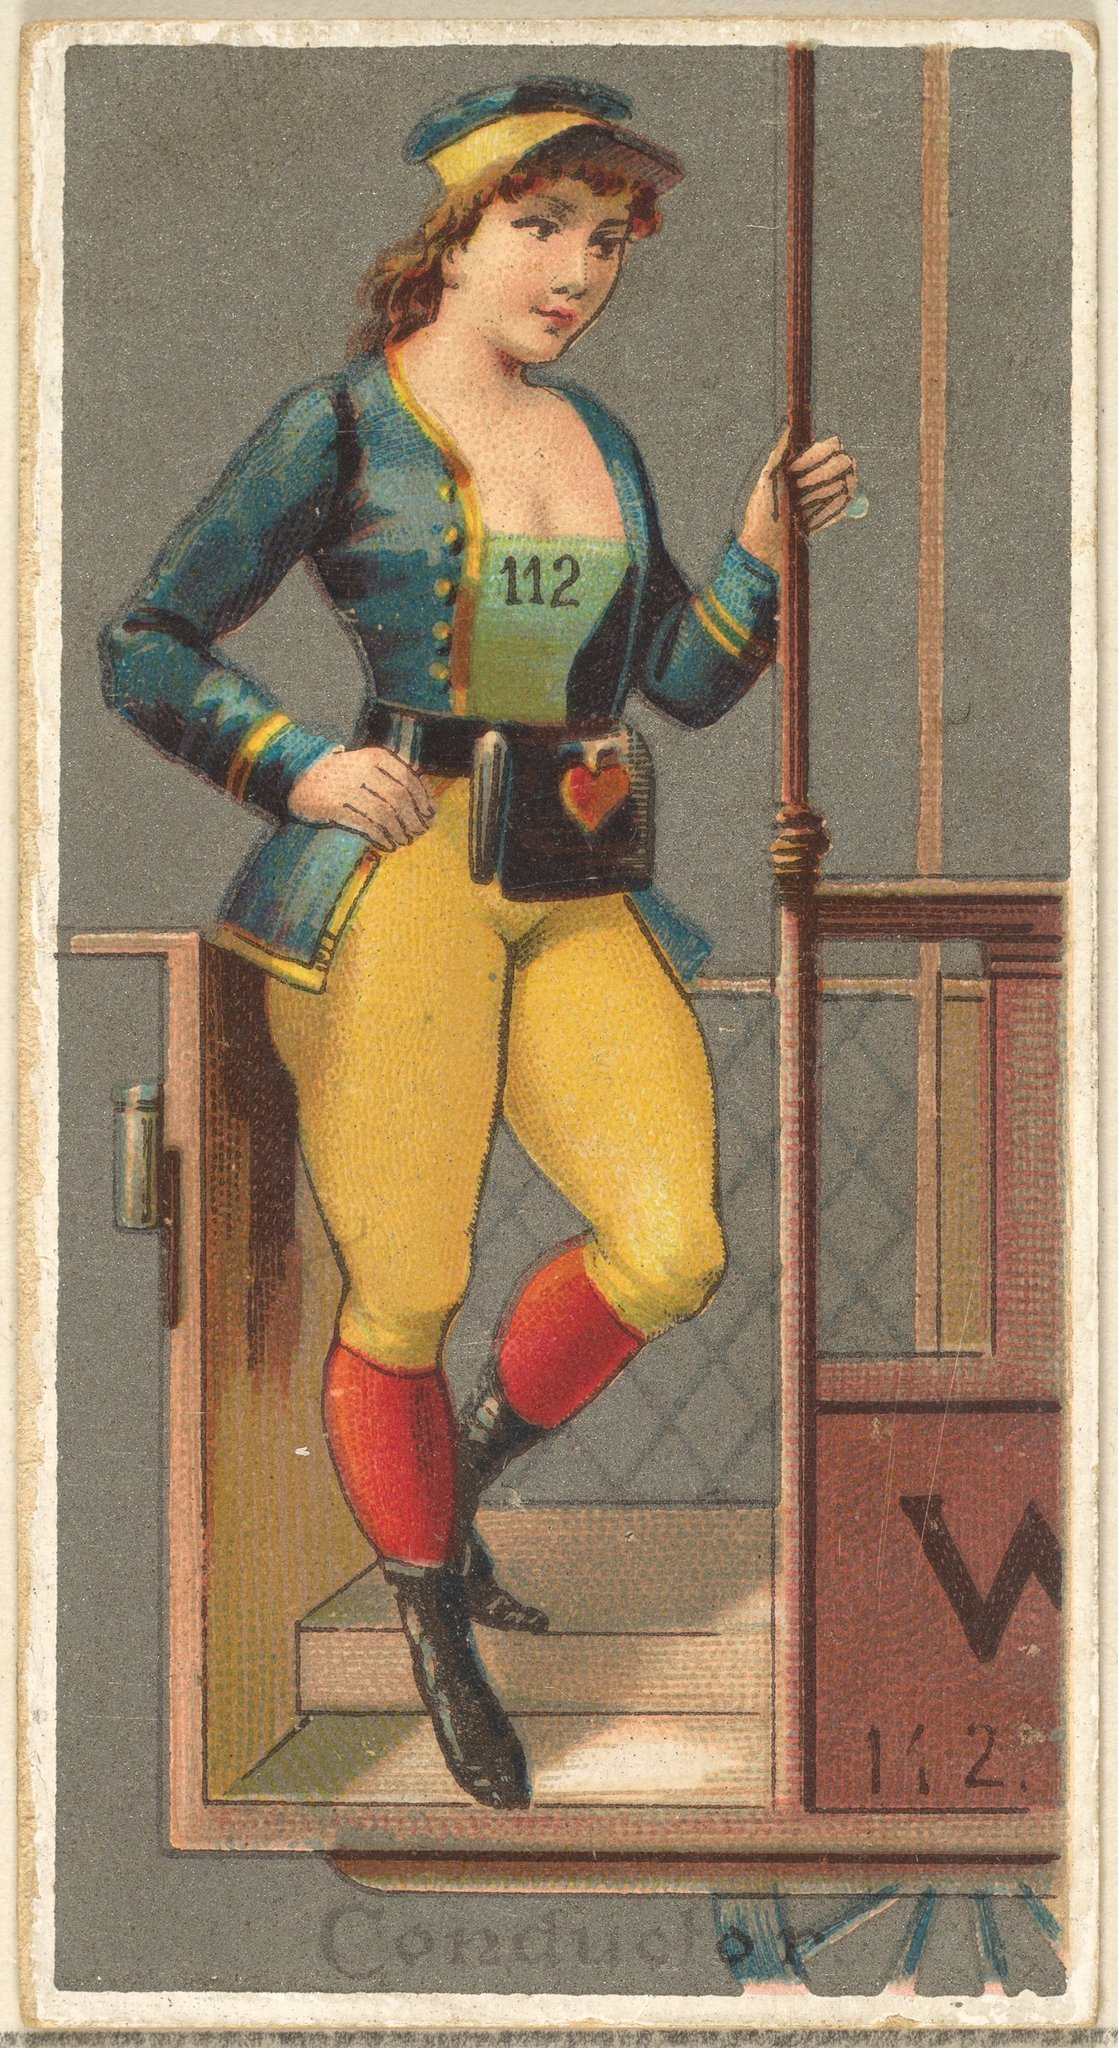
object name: print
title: Conductor, from the Occupations for Women series (N166) for Old Judge and Dogs Head Cigarettes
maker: goodwin & company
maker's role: publisher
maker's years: 1850-1950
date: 1887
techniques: color lithograph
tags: women